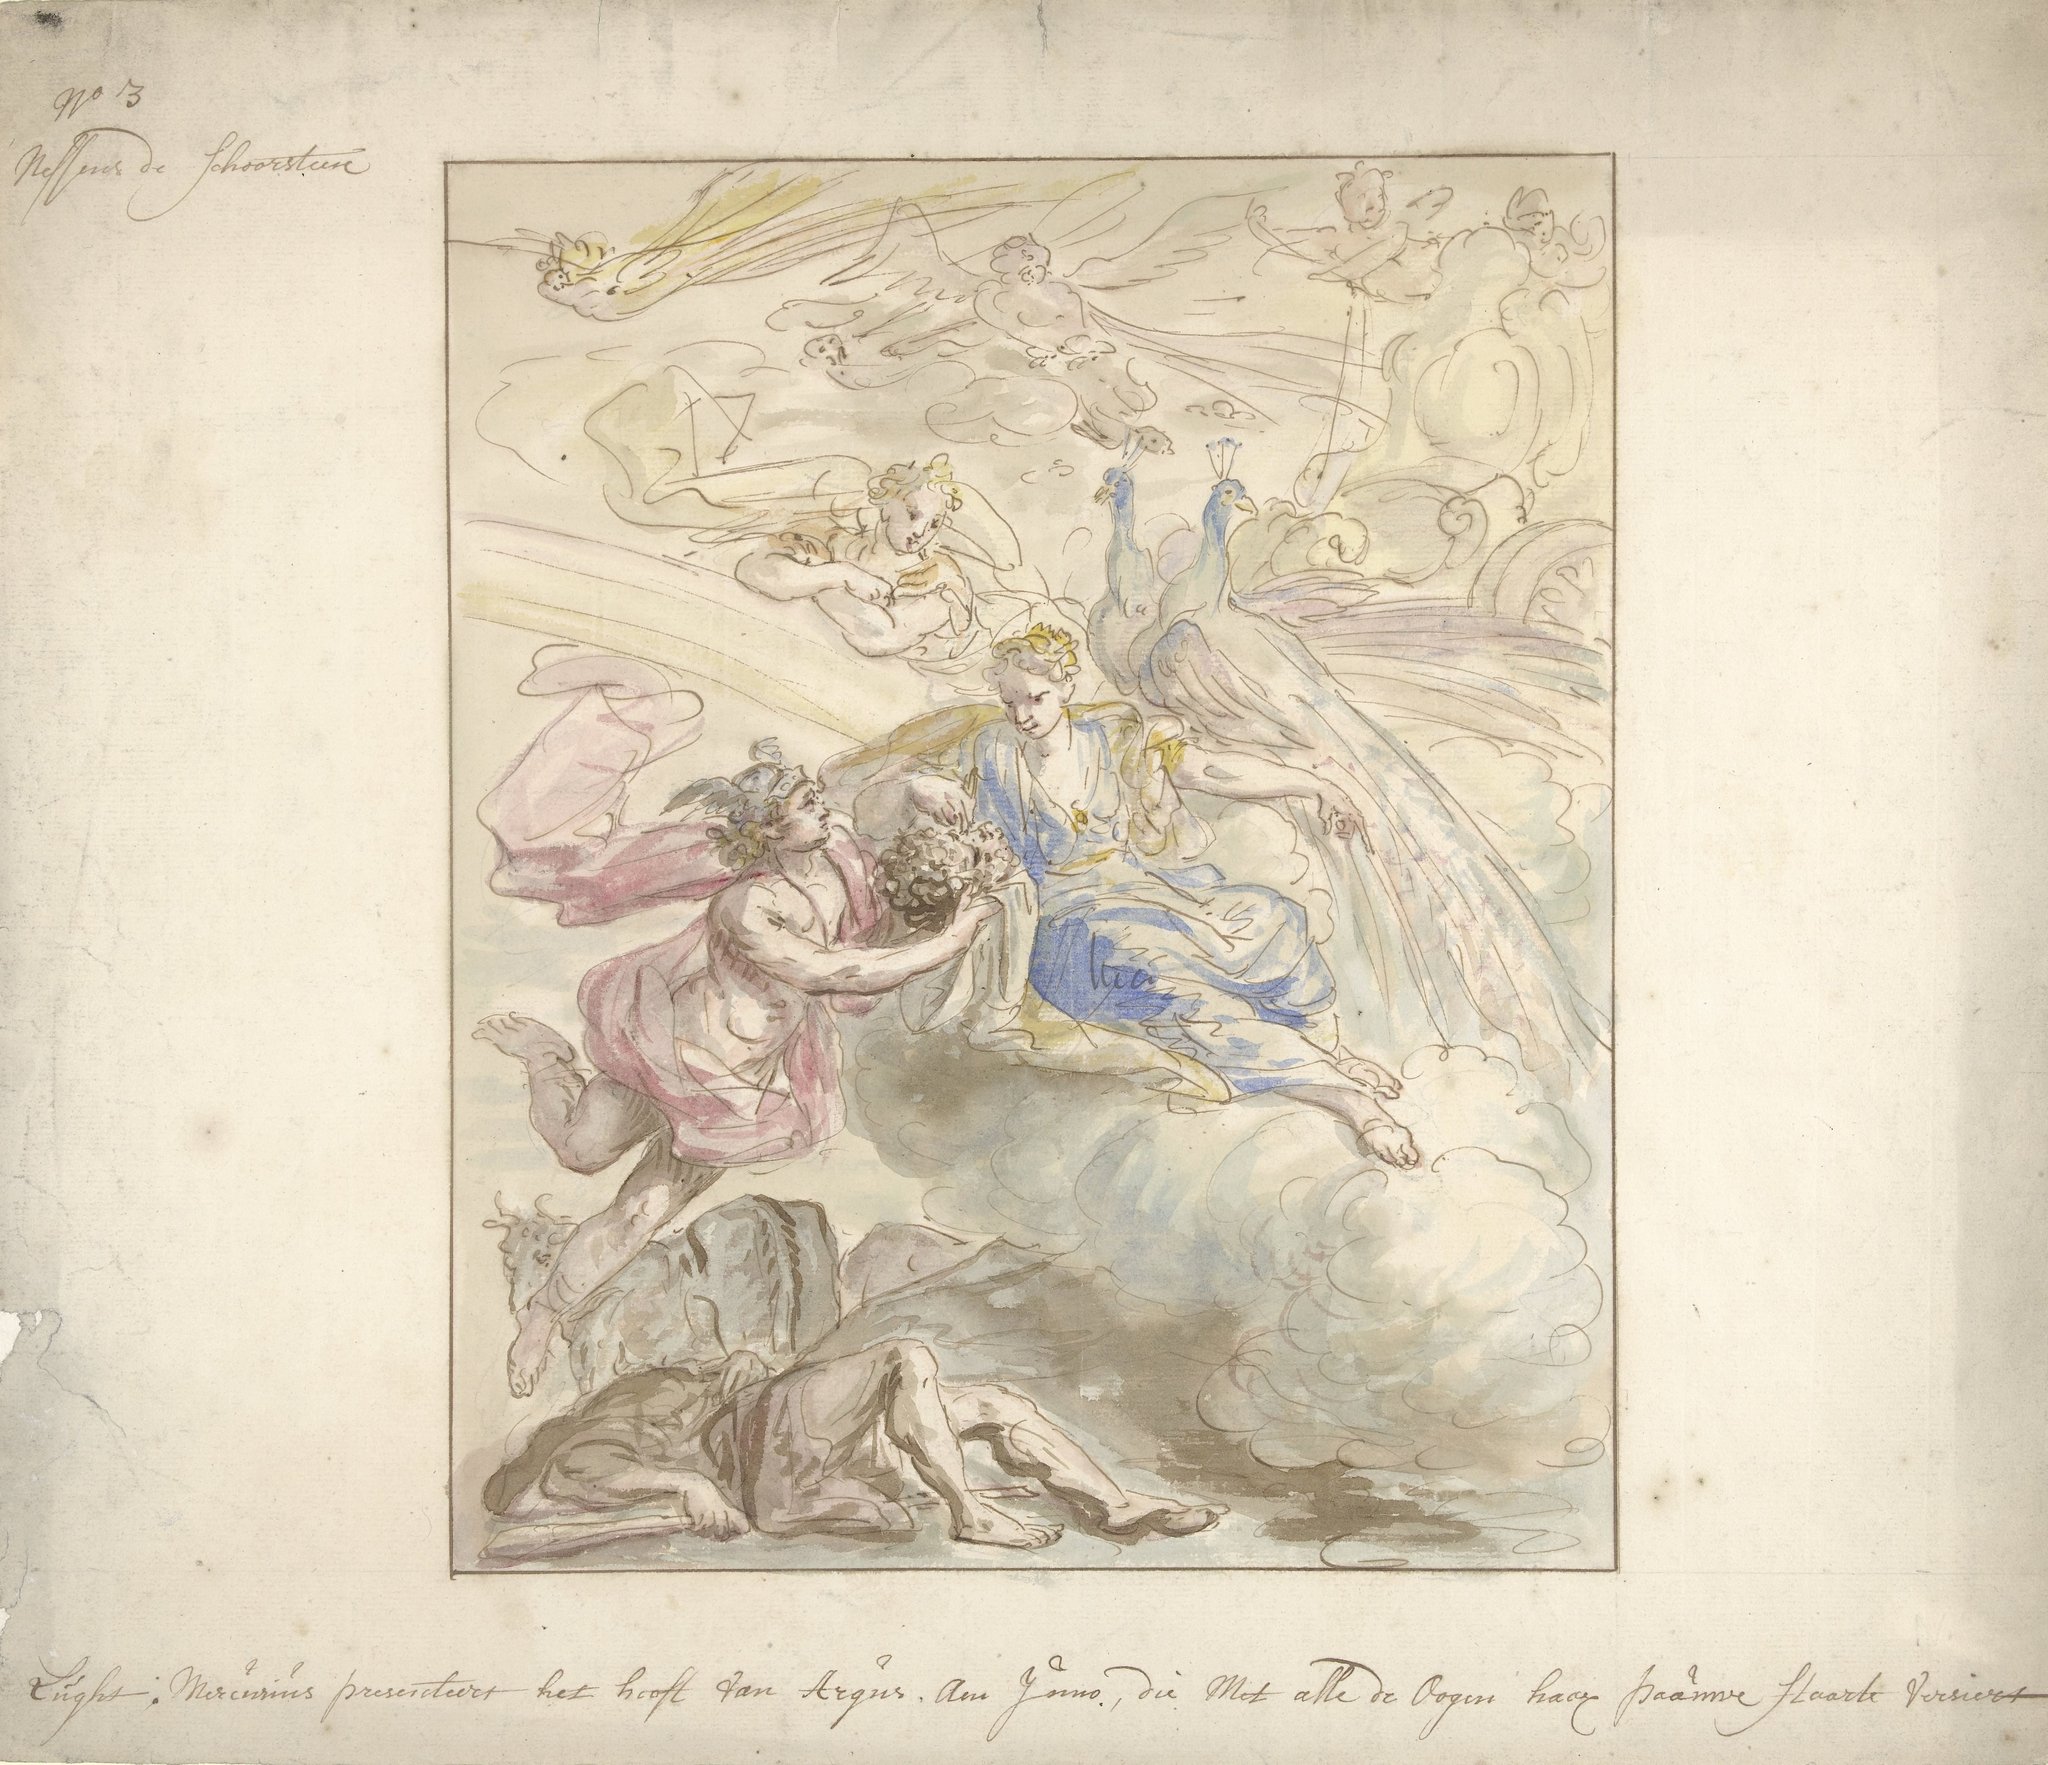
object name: design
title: Ontwerp voor een kamerbeschildering met allegorie op de Lucht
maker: elias van nijmegen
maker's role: draughtsman, painter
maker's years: 1667-1755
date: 1677-1755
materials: ink, paper, pencil, watercolor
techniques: brush, pen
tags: air (one of the four elements), mercury beheads argus, argus' eyes changed into peacock's 'eyes' (ocelli): juno sets argus' eyes on her peacock, after argus, while watching io, has been slain by mercury (ovid, metamorphoses i 723)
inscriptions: inscription: ‘Mercurius presenteert het hoofd van Argus aen Juno, die met alle de Oogen haar paauwe staarte Versiert’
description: Allegorie op de Lucht: Mercurius geeft het hoofd van Argus aan Juno.